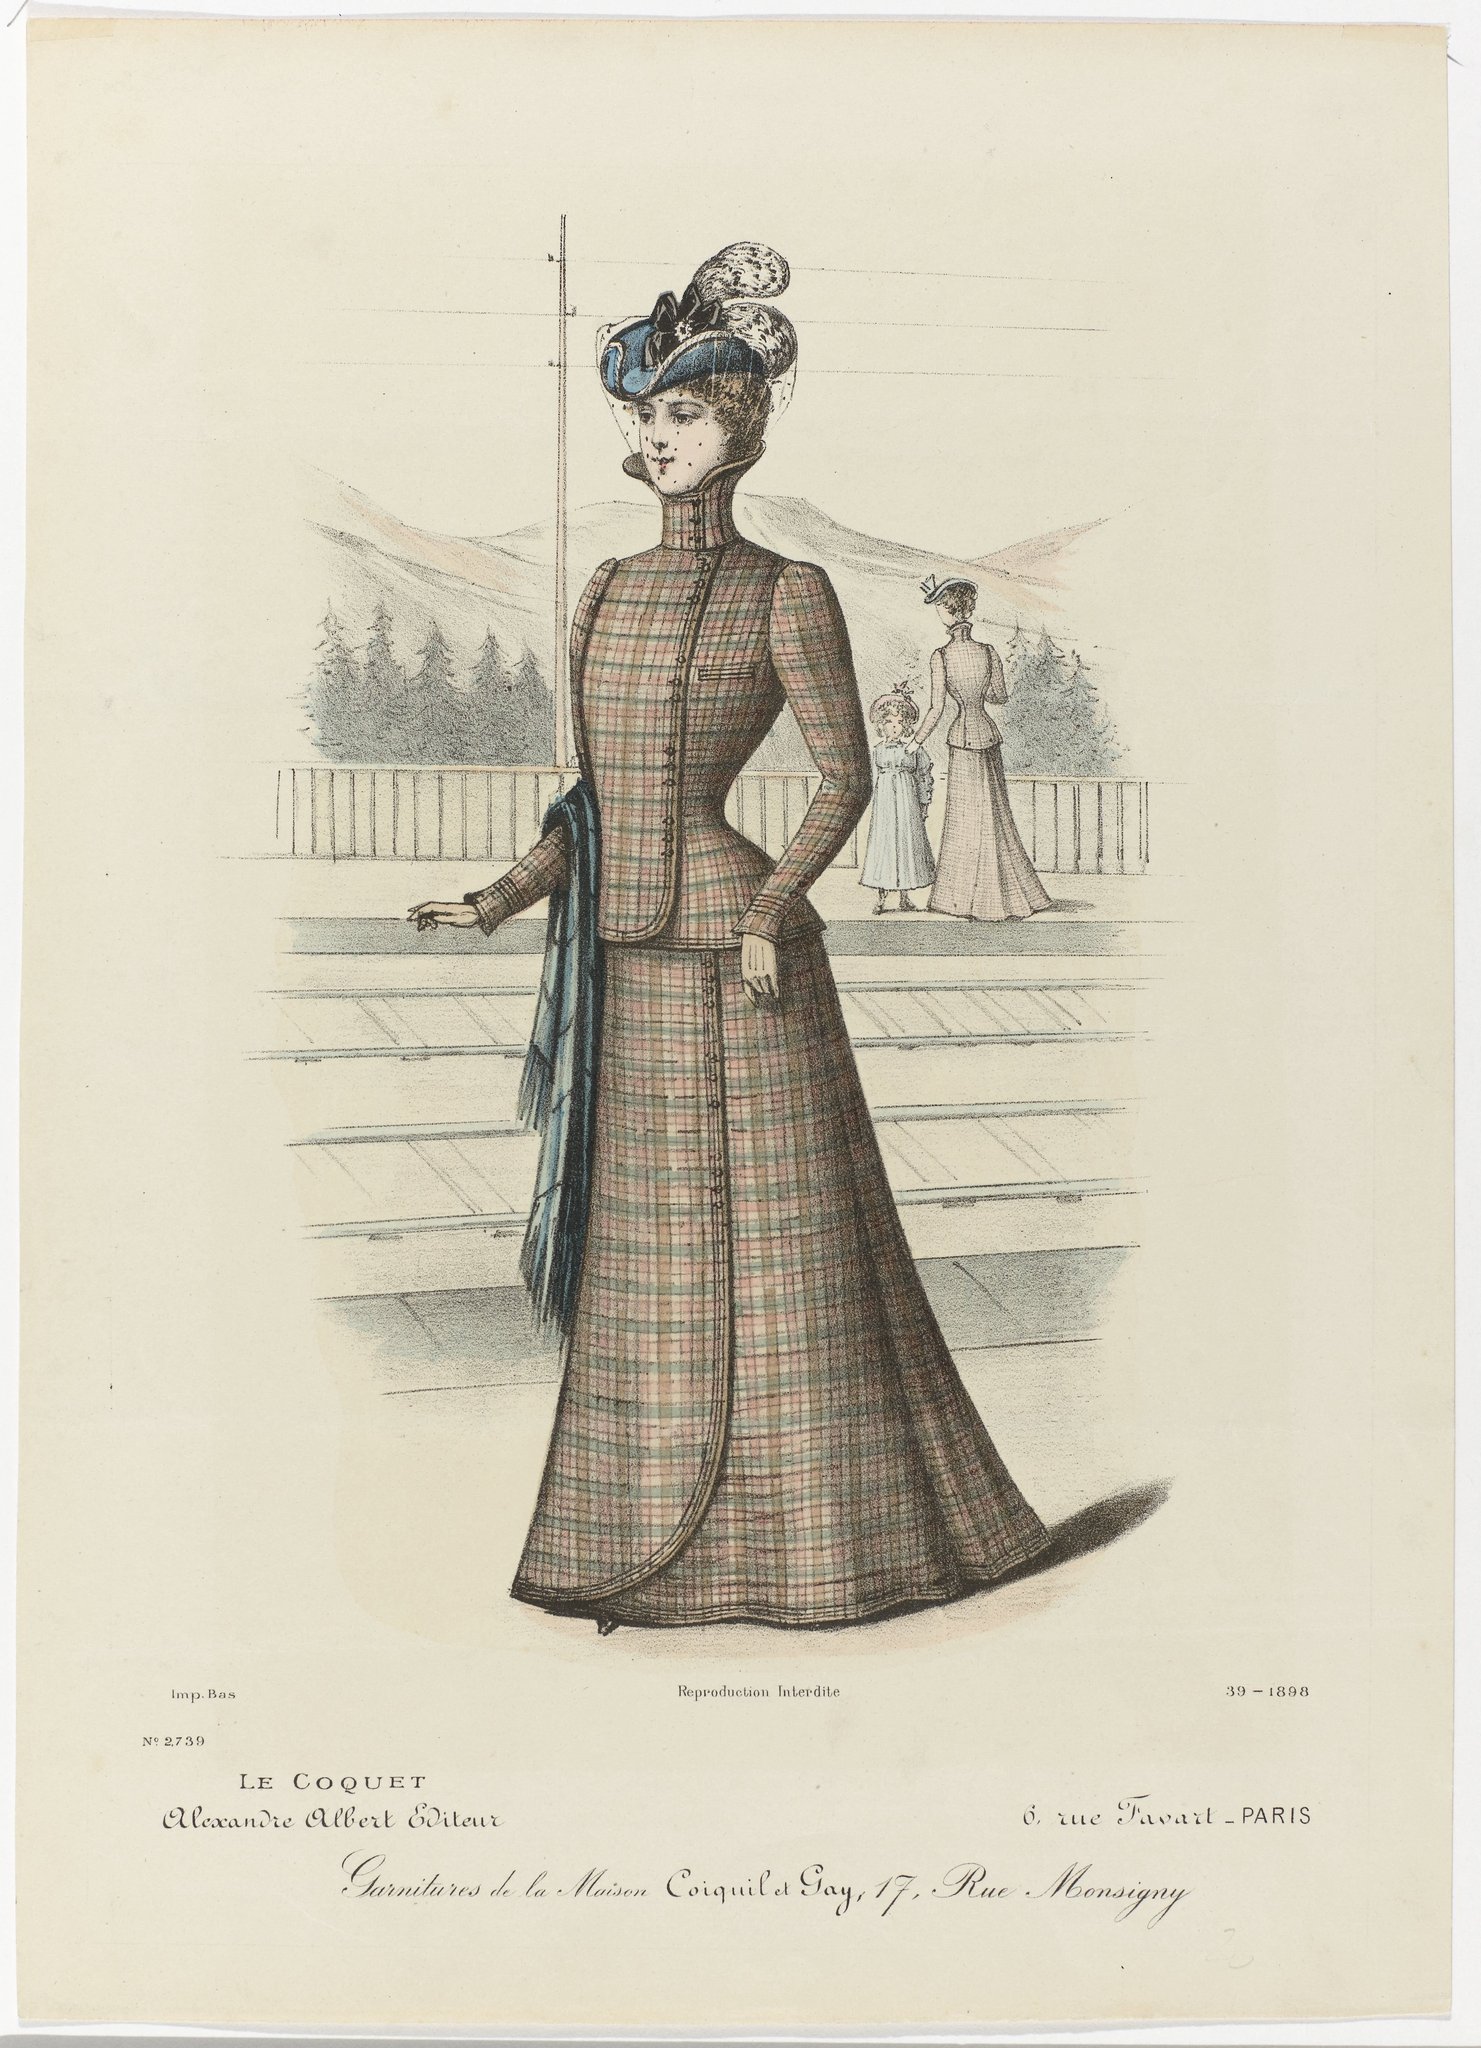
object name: fashion print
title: The First Ladies’ Suit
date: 1898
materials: paper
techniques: hand coloring, lithograph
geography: paris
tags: clothing for the upper part of the body (shawl) (+ women's clothes), veil (+ women's clothes), platform (railway, tramway), coat (+ women's clothes), fashion plates, head-gear: hat (+ women's clothes), skirt (+ women's clothes), mother and daughter(s) (family group)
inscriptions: title: ‘LE COQUET / Alexandre Albert Editeur’, address: ‘Garnitures de la Maison Coiquil et Gay, 17, Rue Monsigny’, address: ‘6, rue Favart_ PARIS’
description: In the 1890s, trends in ladies’ fashion focused particularly on the cut of sleeves. Still puffed up like balloons in the 1895-1896 season, by 1898 sleeves were closefitting once more. Entirely new was the toilette tailleur – a skirt with a matching jacket, such as in the chequered ensemble here – which was perfectly suited for travel. The ladies’ suit was thus born.